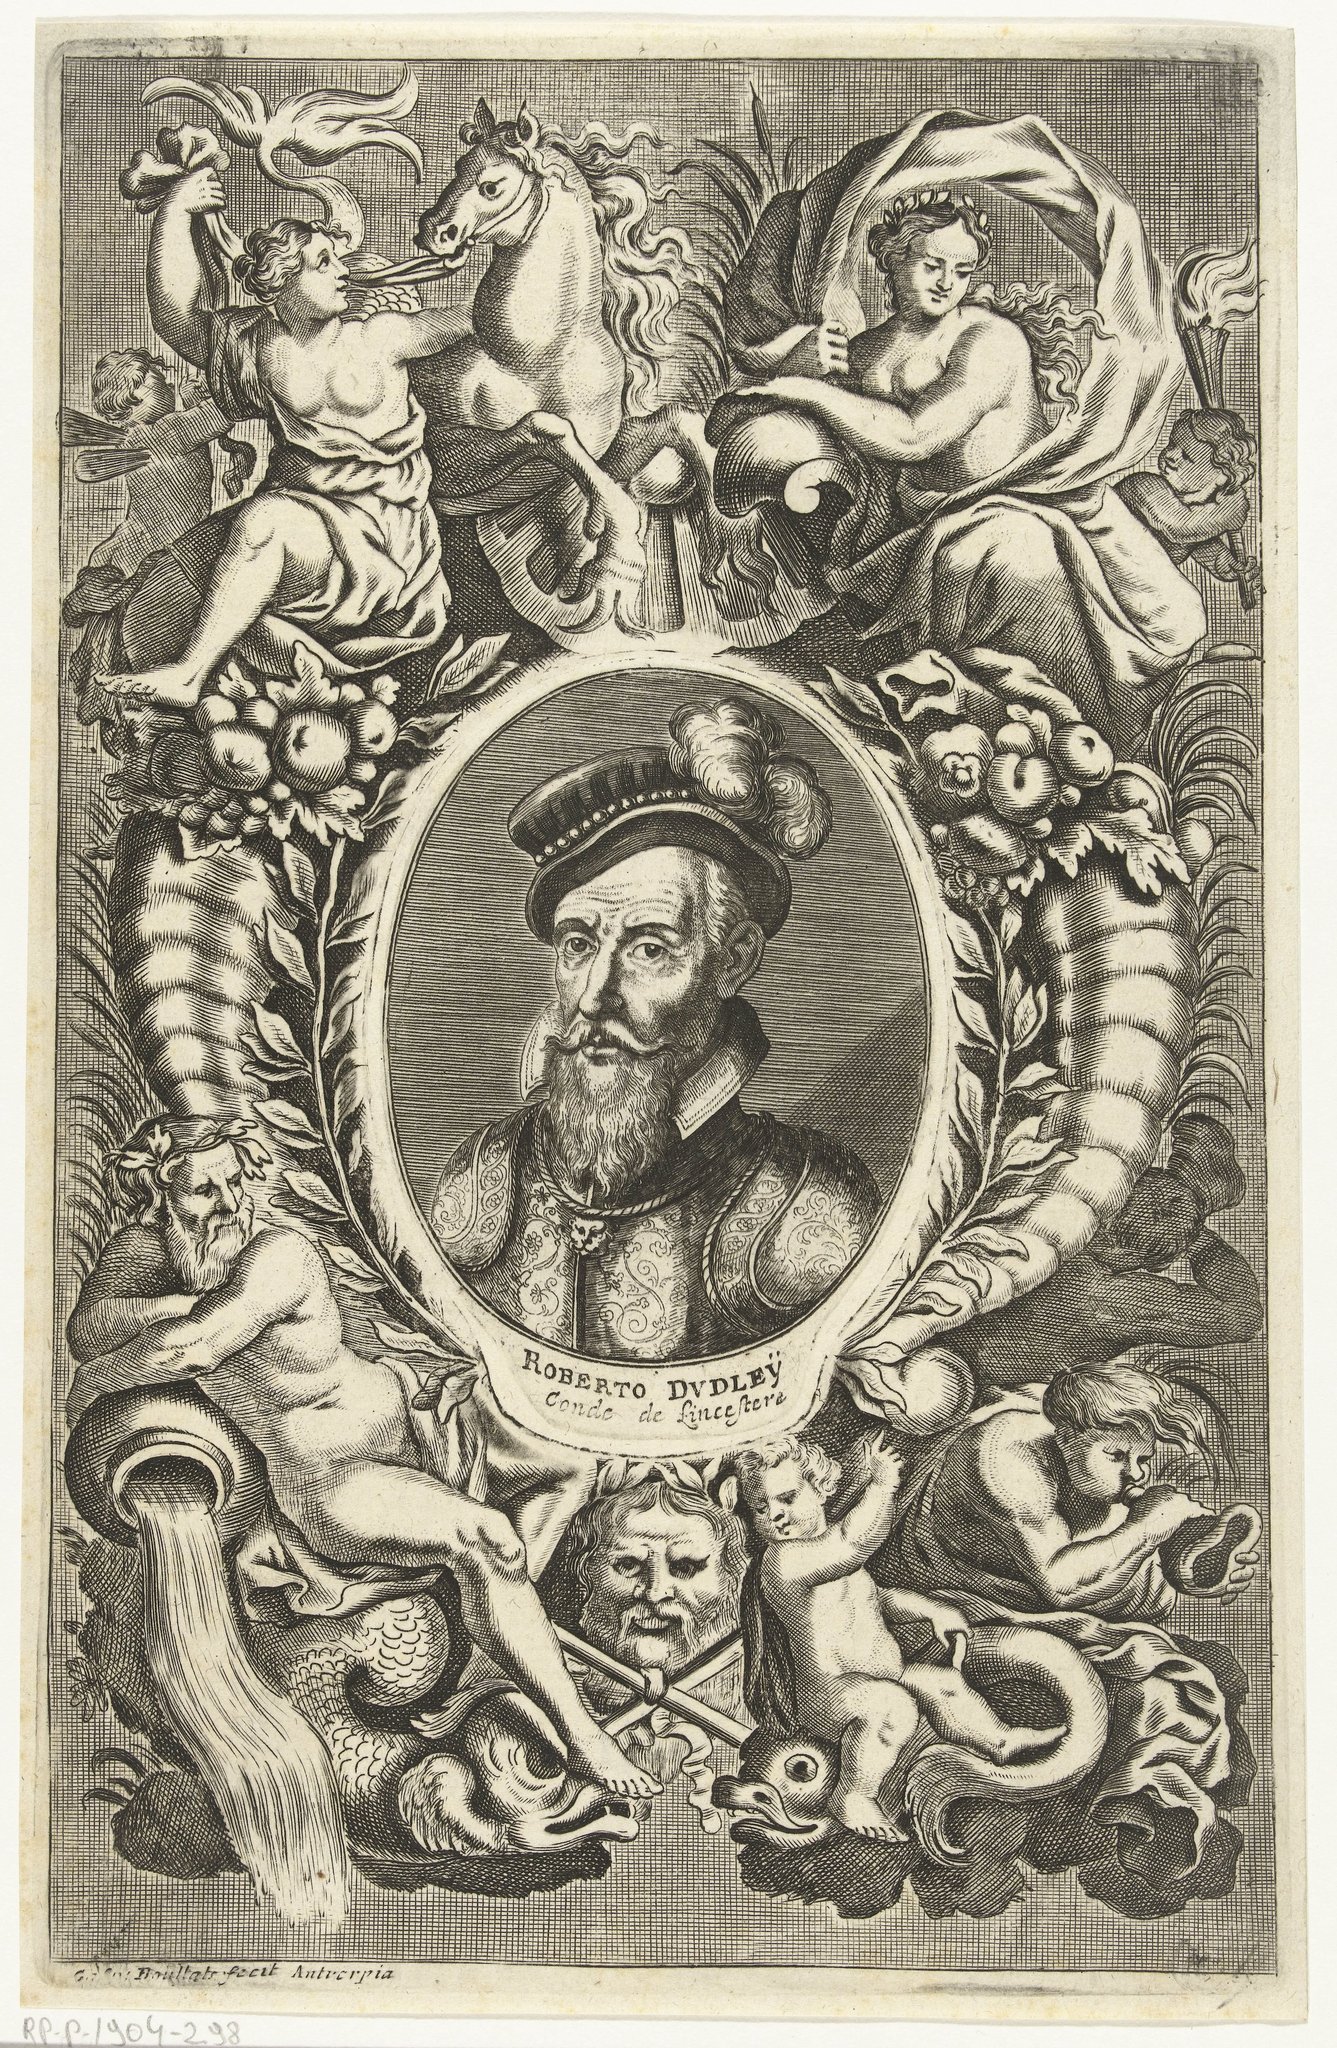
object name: print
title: Portret van Robert Dudley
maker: gaspar bouttats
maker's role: print maker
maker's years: 1640-1695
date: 1650-1695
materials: paper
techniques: engraving, etching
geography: antwerp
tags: robert dudley (1st earl of leicester), other nereids (or sea-nymphs)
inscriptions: collector's mark: Lugt 2228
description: Portret in ovale lijst van Robert Dudley, graaf van Leicester, in harnas. Buste links frontaal. Rond de omlijsting van het portret waternimfen en watercreaturen.